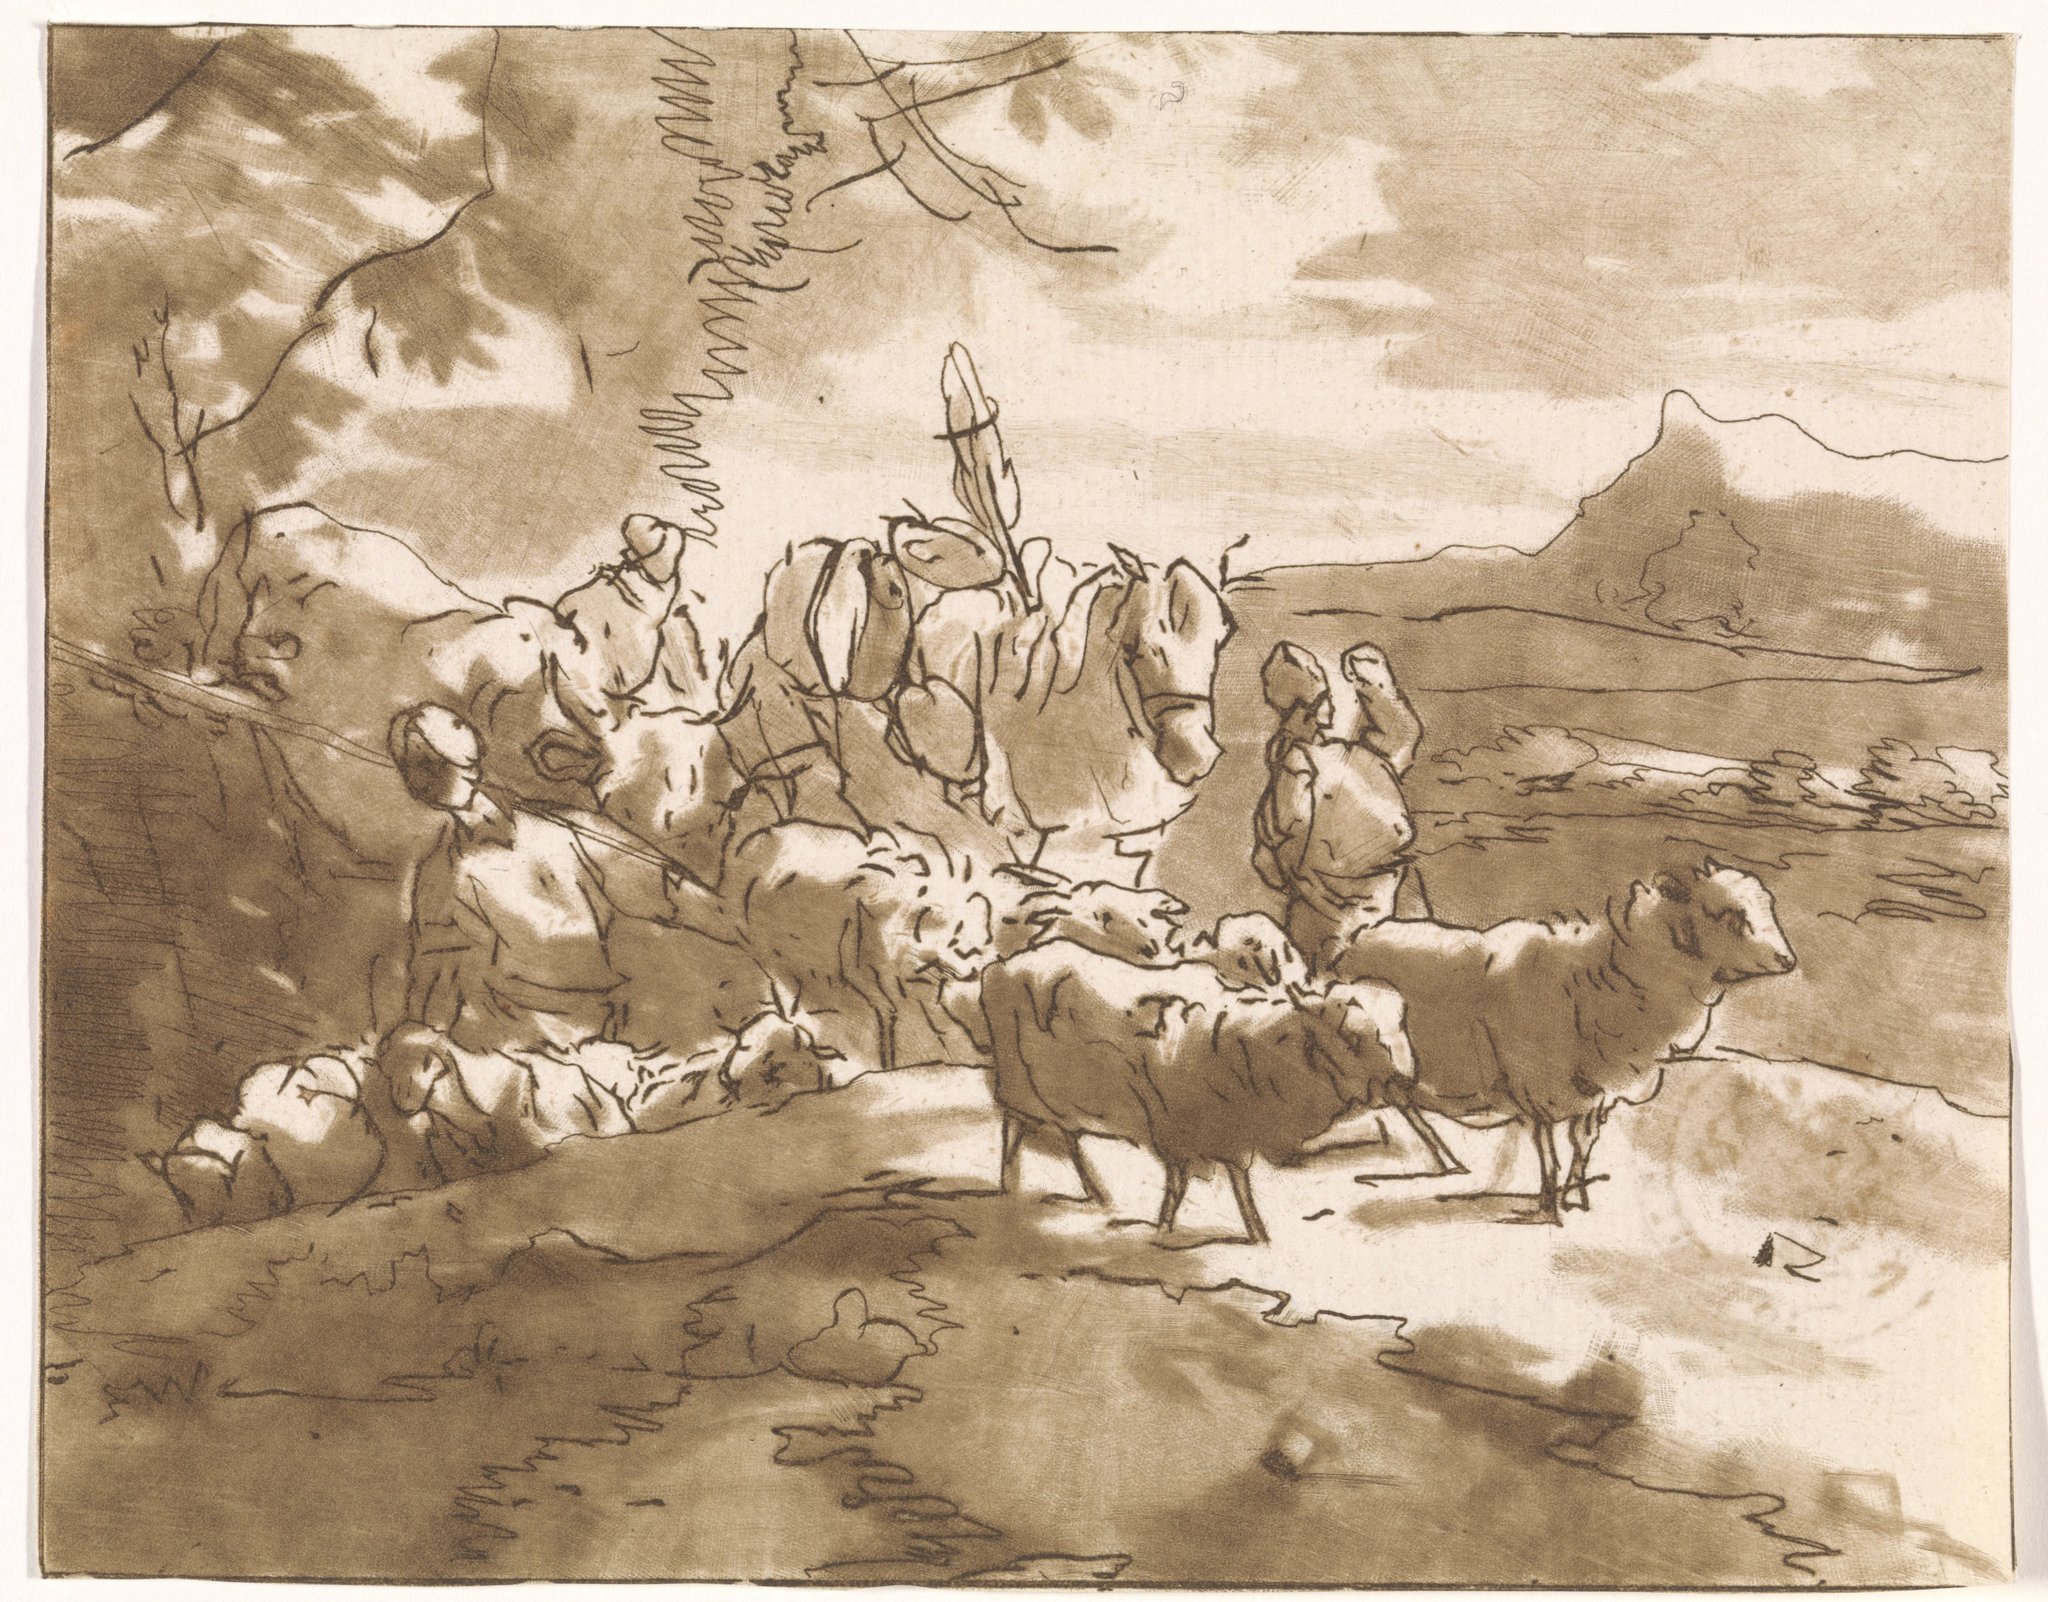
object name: print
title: Herders met vee in een berglandschap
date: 1769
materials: paper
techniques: aquatint, etching, roulette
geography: amsterdam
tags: herding, herdsman, herdswoman, shepherd, shepherdess, cowherd, etc., (high) hill, cattle driving, cattle driver, sheep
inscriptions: collector's mark: Lugt 240